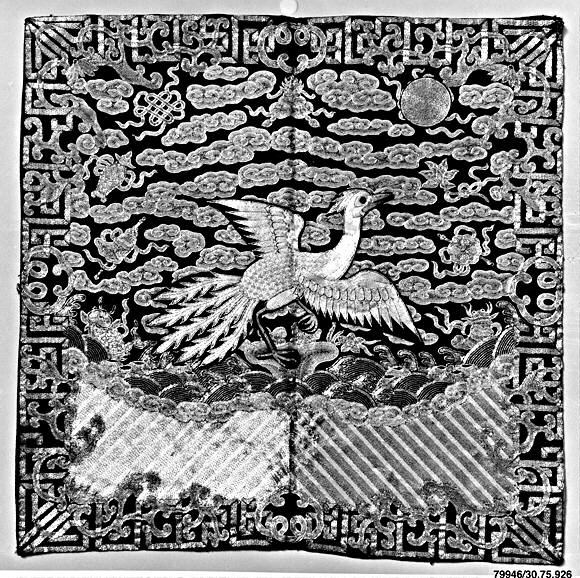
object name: rank badge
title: Rank Badge with Silver Pheasant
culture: chinese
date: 1767-1833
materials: metal thread, silk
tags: pheasants